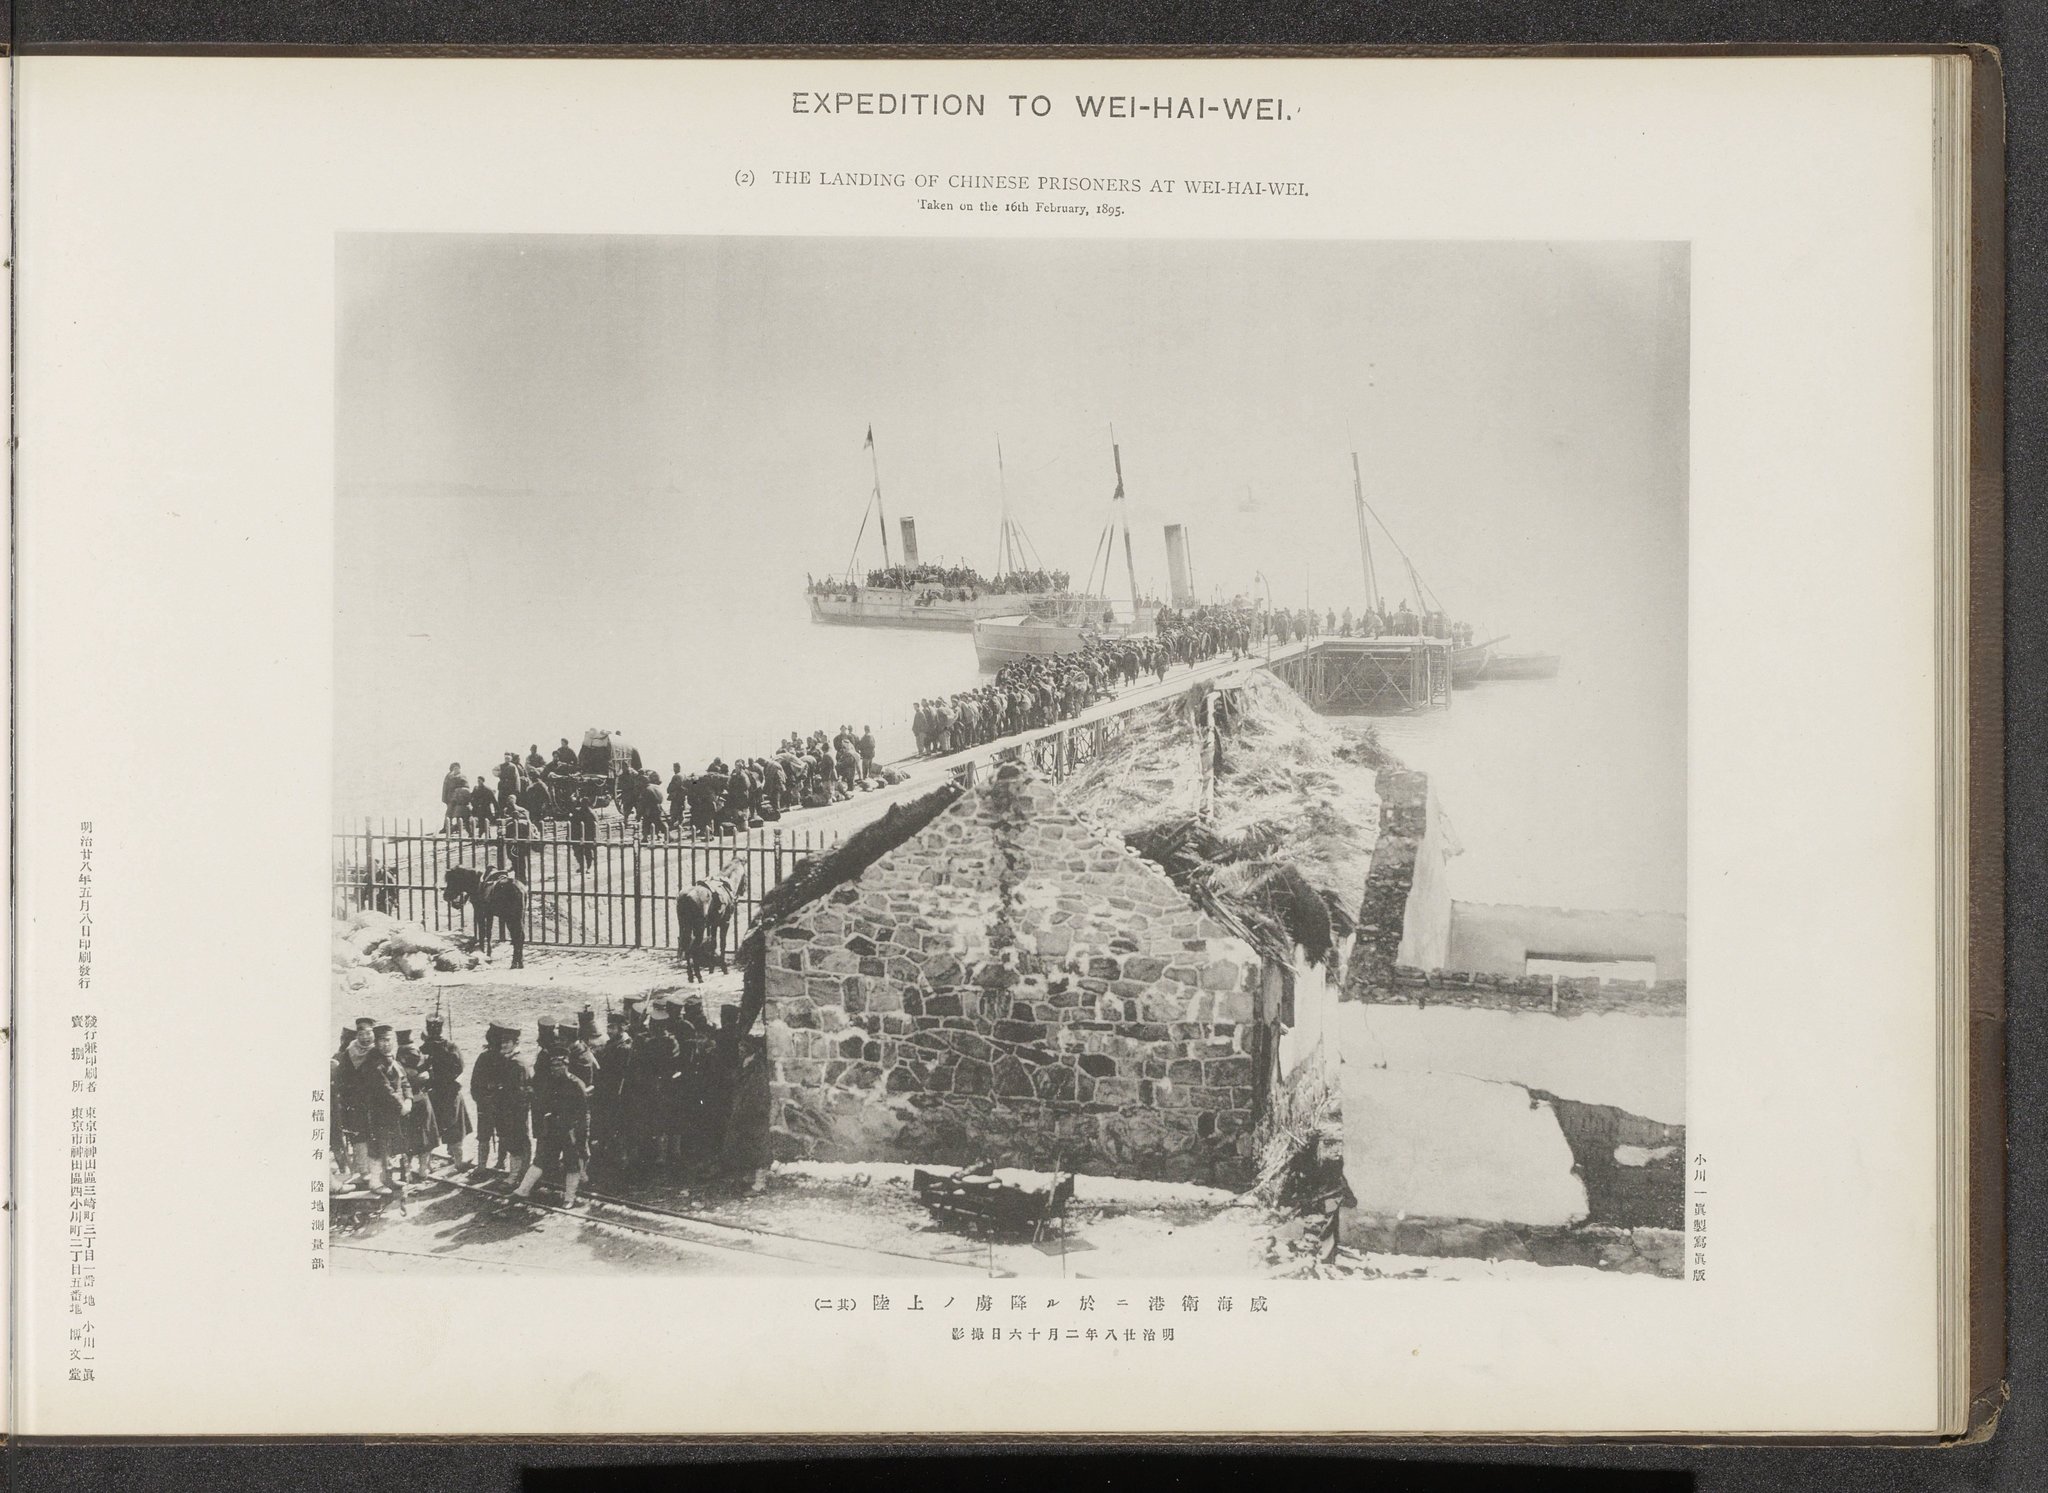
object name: photomechanical print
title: The landing of Chinese prisoners at Wei-Hai-Wei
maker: kazumasa ogawa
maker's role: auteur, fotograaf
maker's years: 1860-1929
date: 1895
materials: paper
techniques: photograph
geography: japan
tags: transfer, deportation ~ prisoner of war, prisoner of war (after the battle)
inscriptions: inscription: ‘Expedition to Wei-Hai-Wei.’